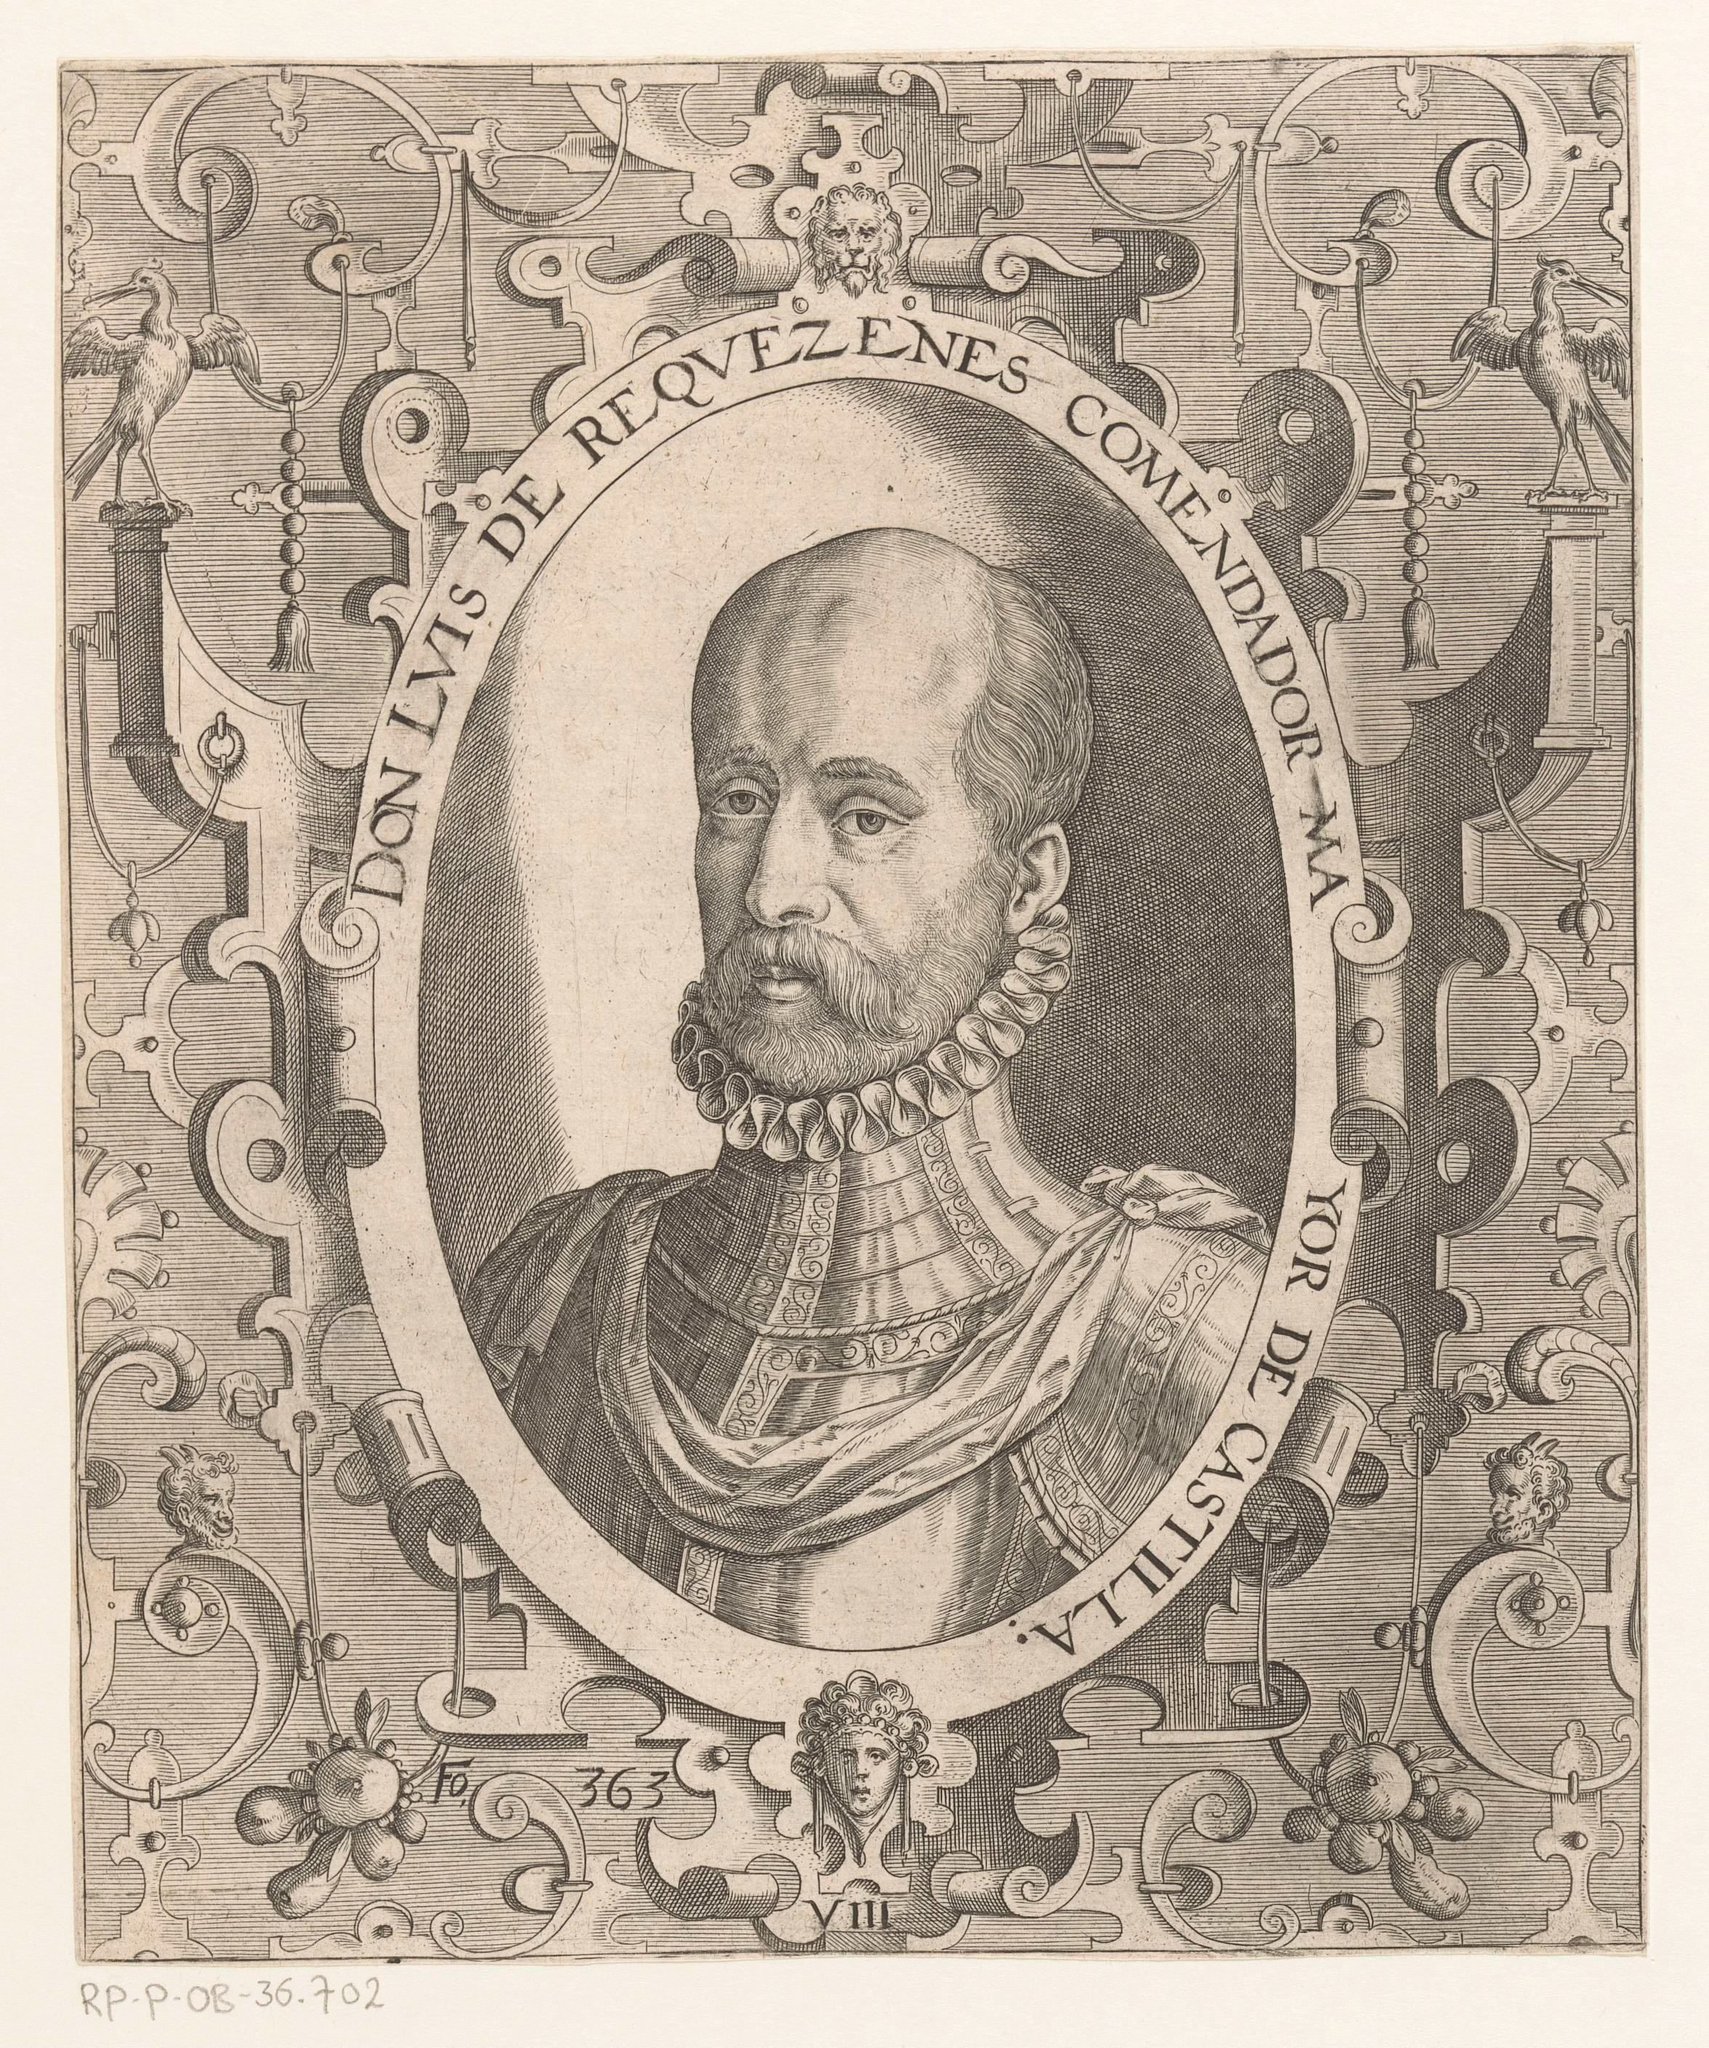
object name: print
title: Portretten van vorsten en andere illustere figuren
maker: niccolò nelli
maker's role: print maker, publisher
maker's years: 1535-1585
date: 1569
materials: paper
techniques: engraving, etching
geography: venice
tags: brussels, mayor, luis de zúñiga y requesens, ornament derived from animal forms, fruits and vegetables ~ ornament, historical persons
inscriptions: collector's mark: Lugt 2228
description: Prent uit een serie portretten van onbekende omvang getiteld 'Imagines Quorundam Principum et Illustrium Virorum' met prenten door Niccolò Nelli, Domenico Zenoi, Martino Rota, Nicolas Bèatrizet en Cornelis Cort, uitgegeven in 1569 te Venetië.